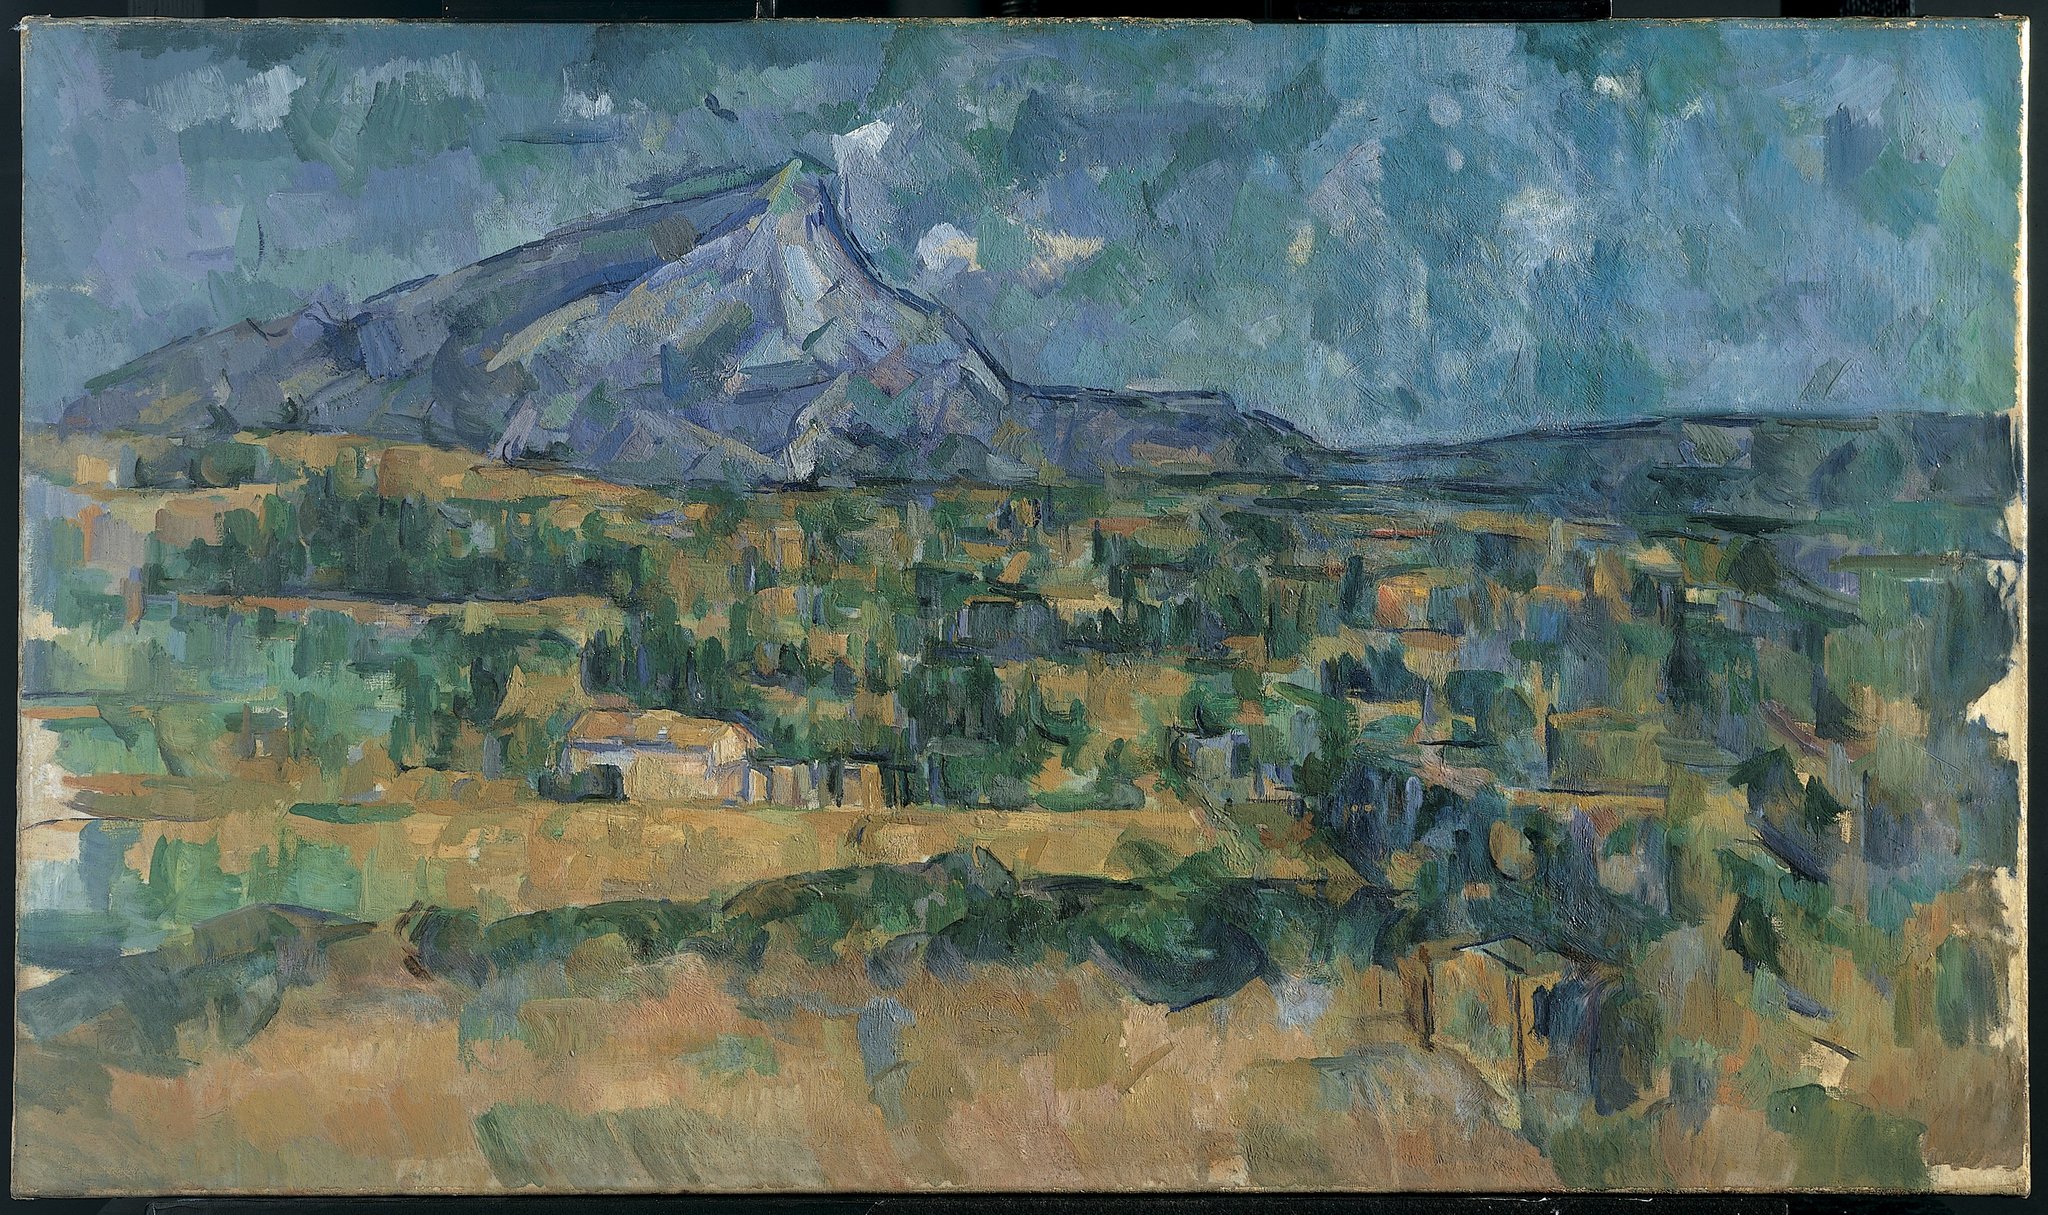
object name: painting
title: Mont Sainte-Victoire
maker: paul cézanne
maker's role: artist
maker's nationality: french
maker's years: 1839-1906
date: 1902-1906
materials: canvas, oil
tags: mountains,landscapes